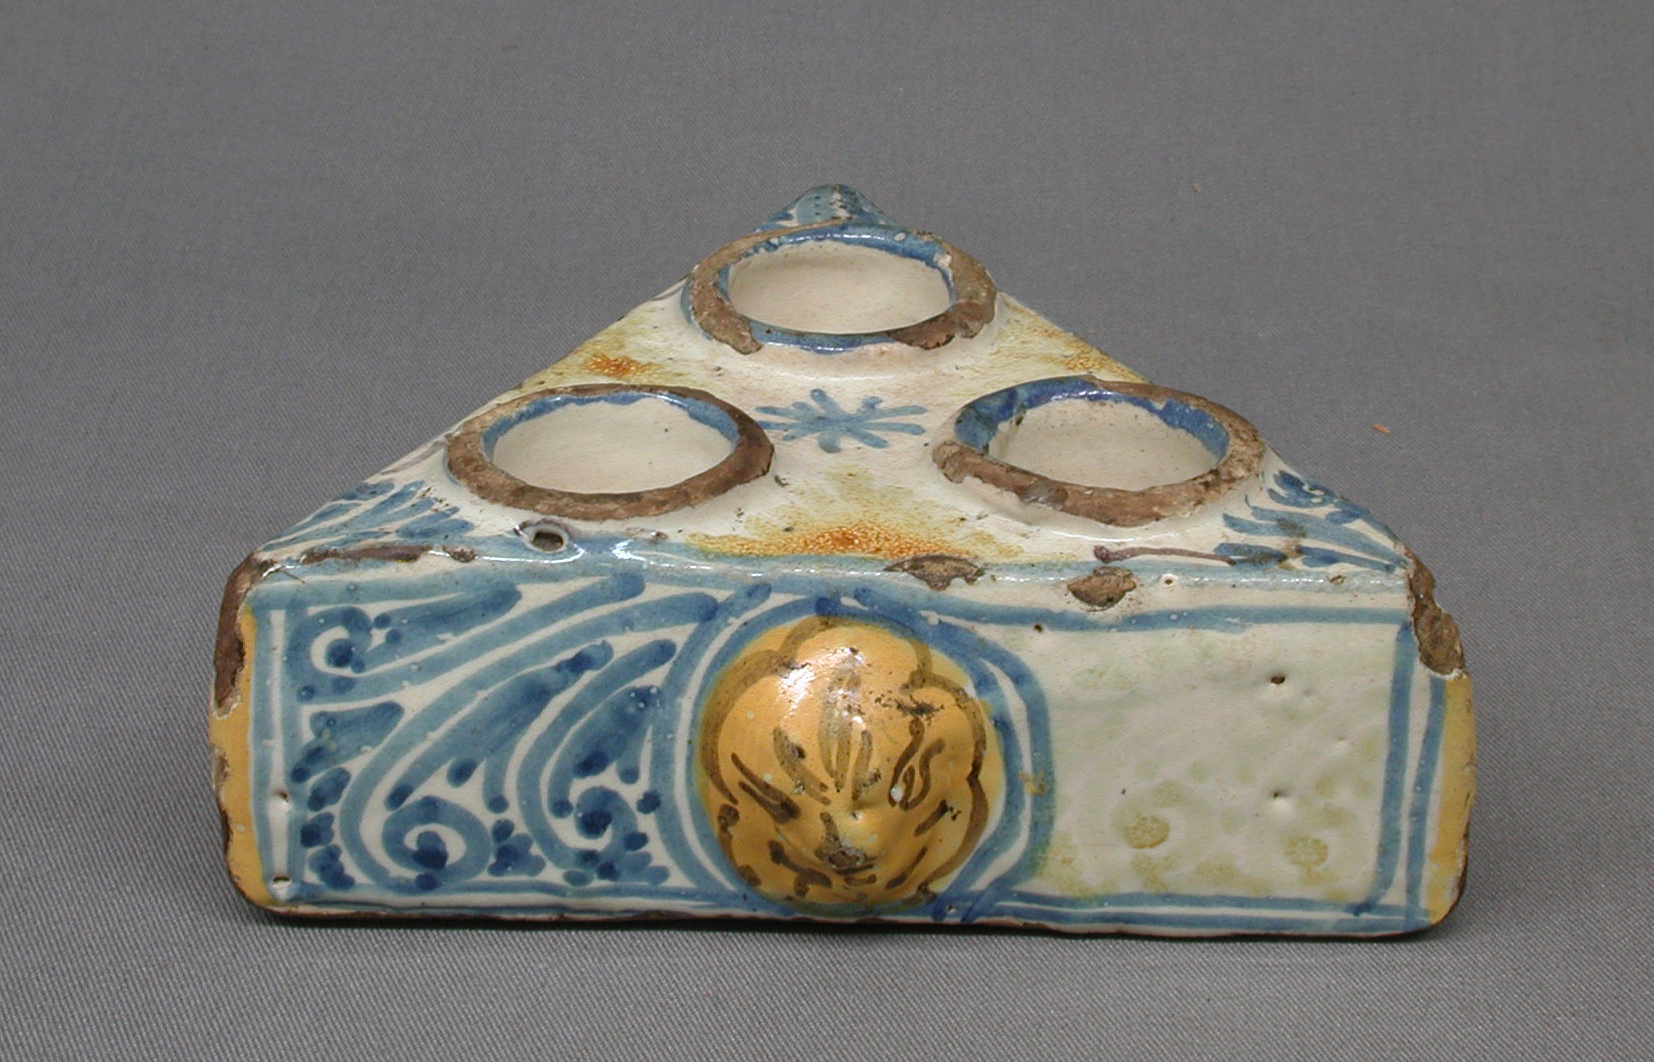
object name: saltcellar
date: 1601-1633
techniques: maiolica, glazing